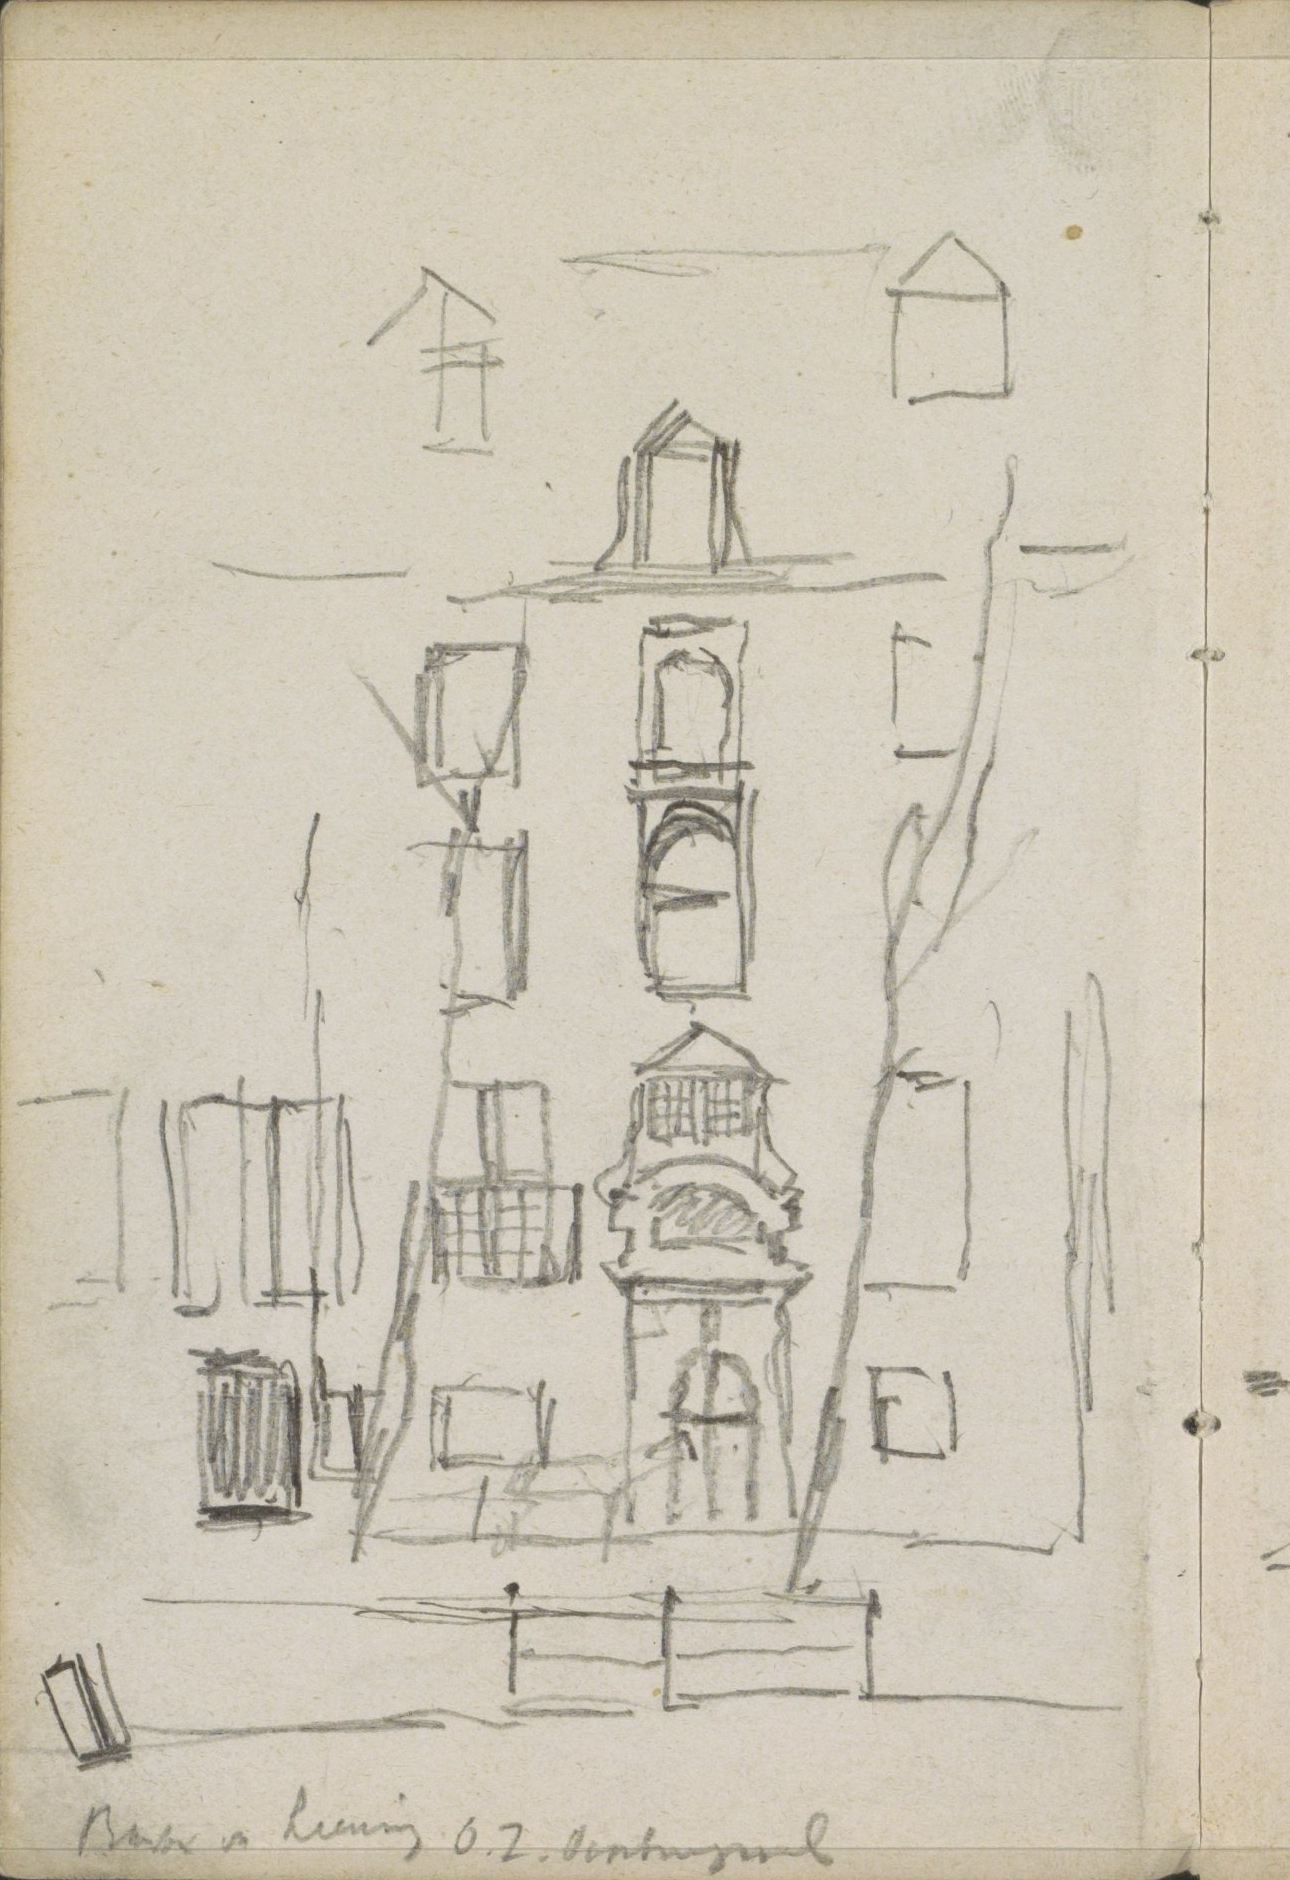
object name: sketchbook leaf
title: Stadsbank van Lening aan de Oudezijds Voorburgwal te Amsterdam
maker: george hendrik breitner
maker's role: draughtsman, painter, print maker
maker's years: 1857-1923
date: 1902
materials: paper, pencil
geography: amsterdam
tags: urban housing, bank, street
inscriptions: annotation: ‘Bank van Leening O.Z. Voorburgwal’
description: Pagina 3 uit een schetsboek met 46 bladen vervaardigd in de omgeving van Amsterdam, Rotterdam en Haarlem.